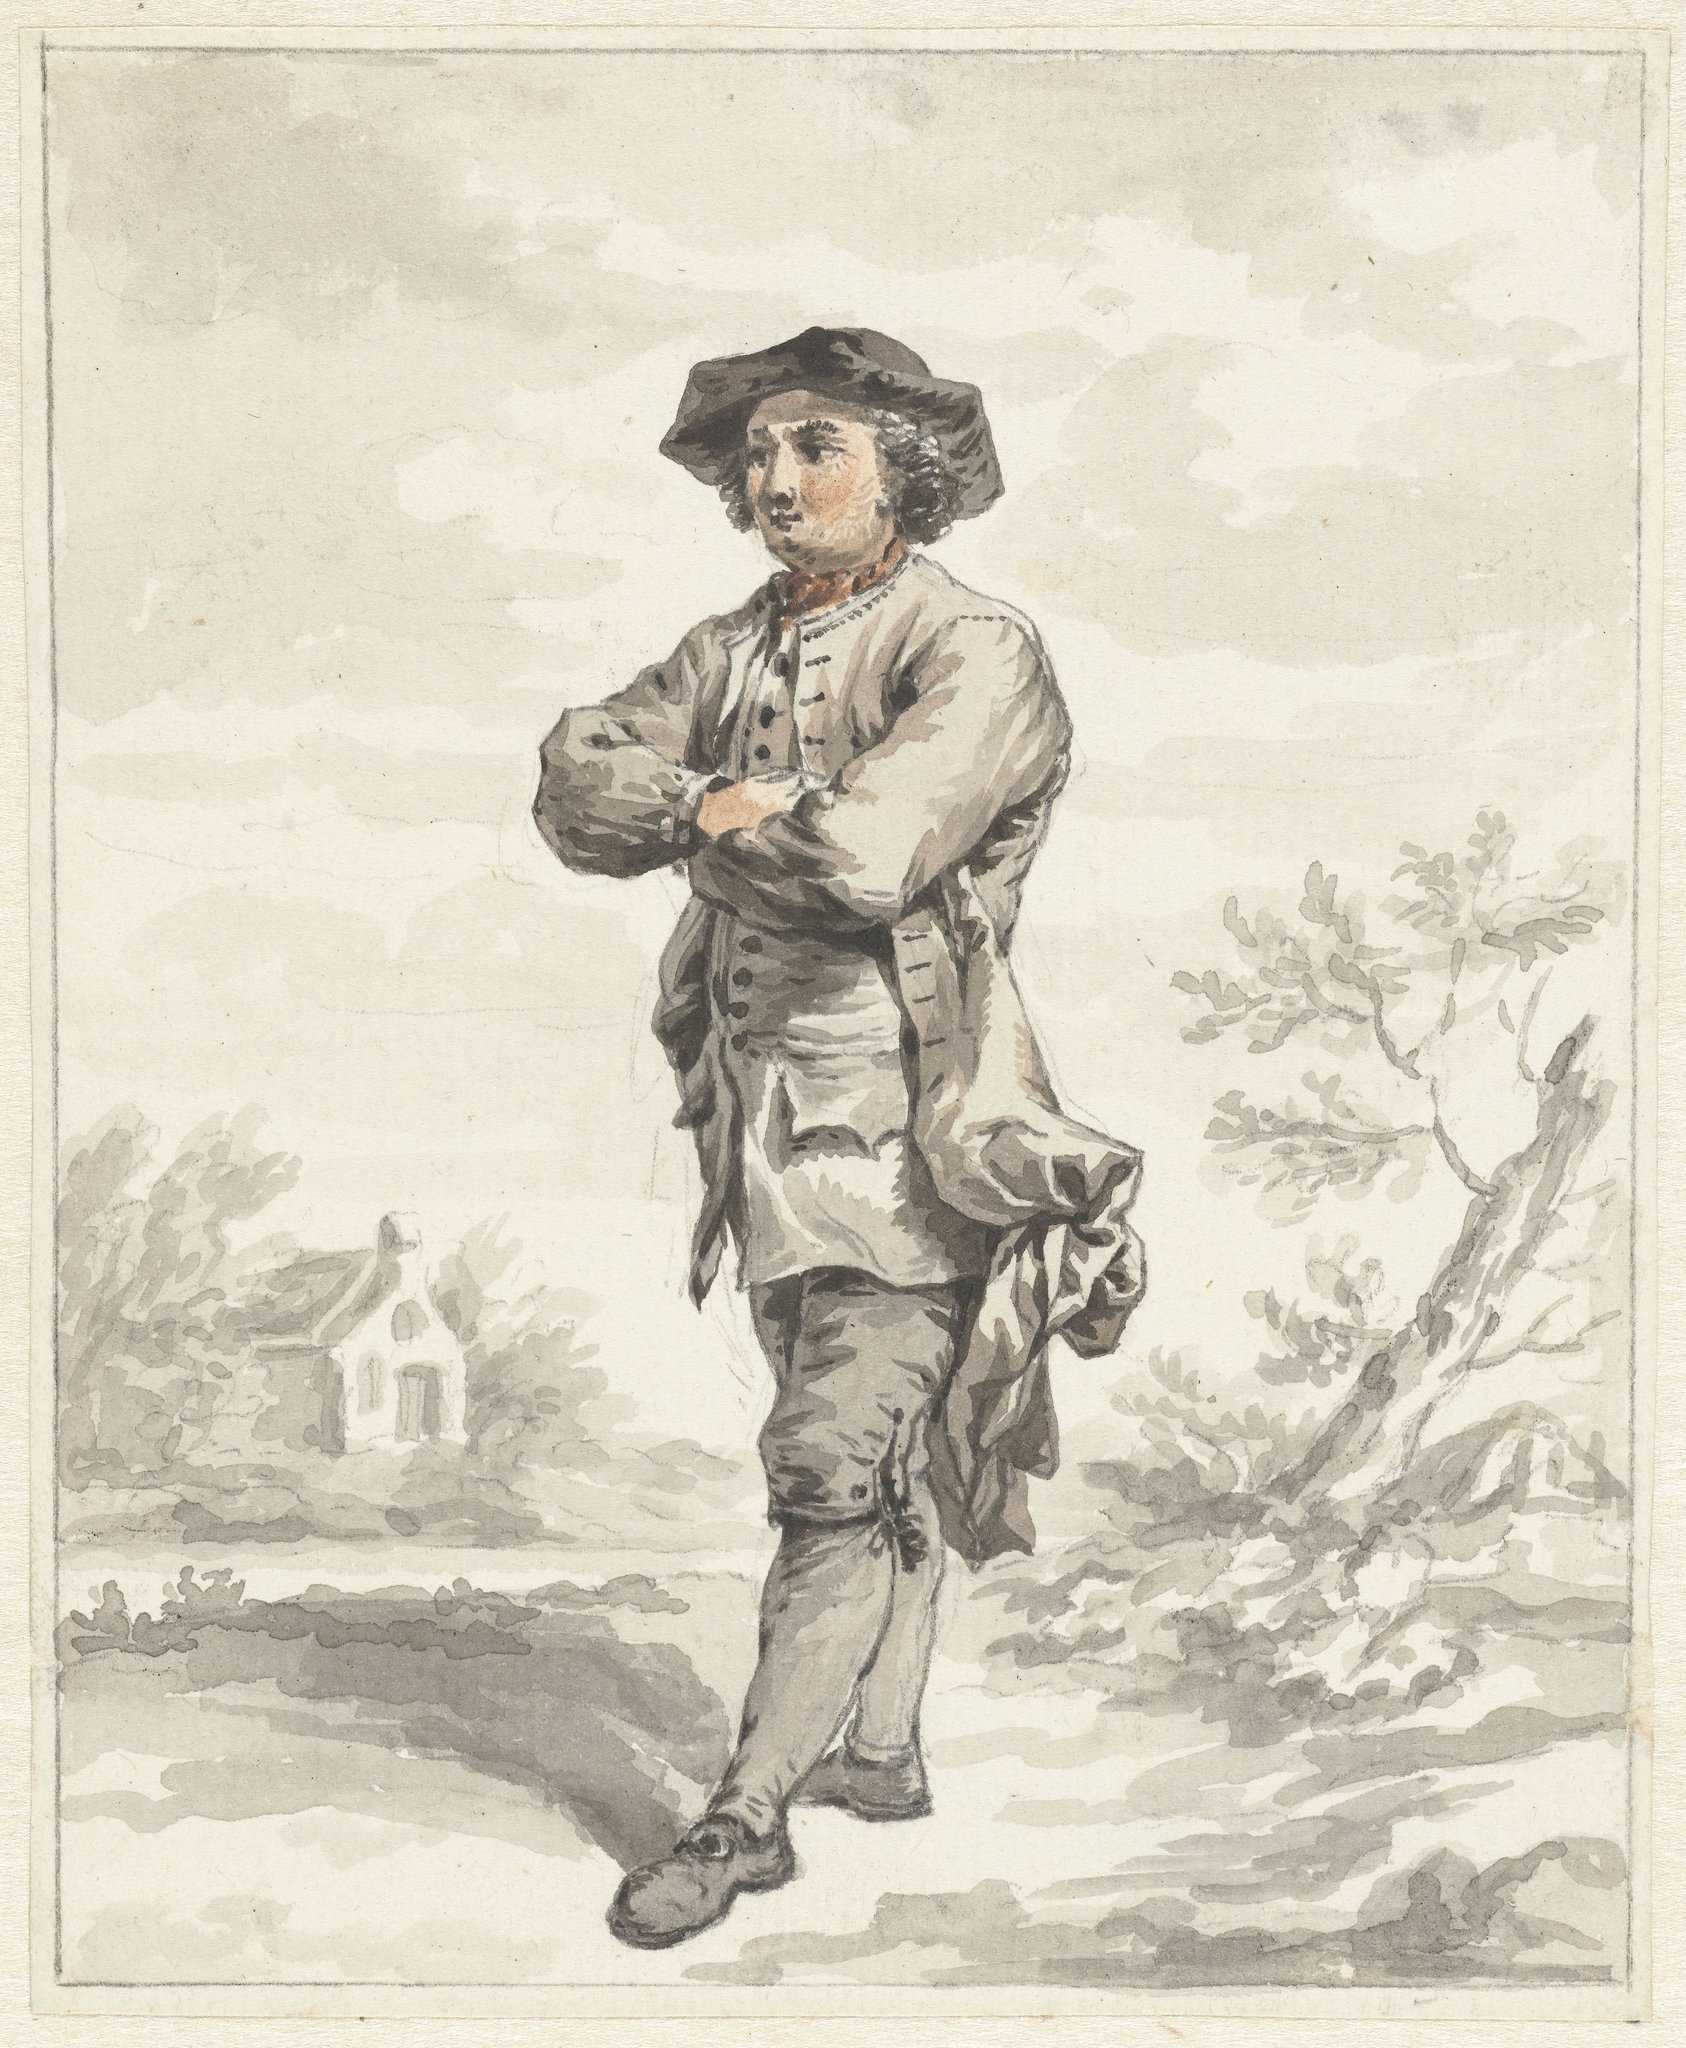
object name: drawing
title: Staande man, de armen over elkaar geslagen, naar links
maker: abraham van strij (i)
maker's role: draughtsman, painter, print maker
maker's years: 1753-1826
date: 1763-1826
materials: ink, paper, pencil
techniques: brush, pen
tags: postures of the human figure, arms crossed over the breast